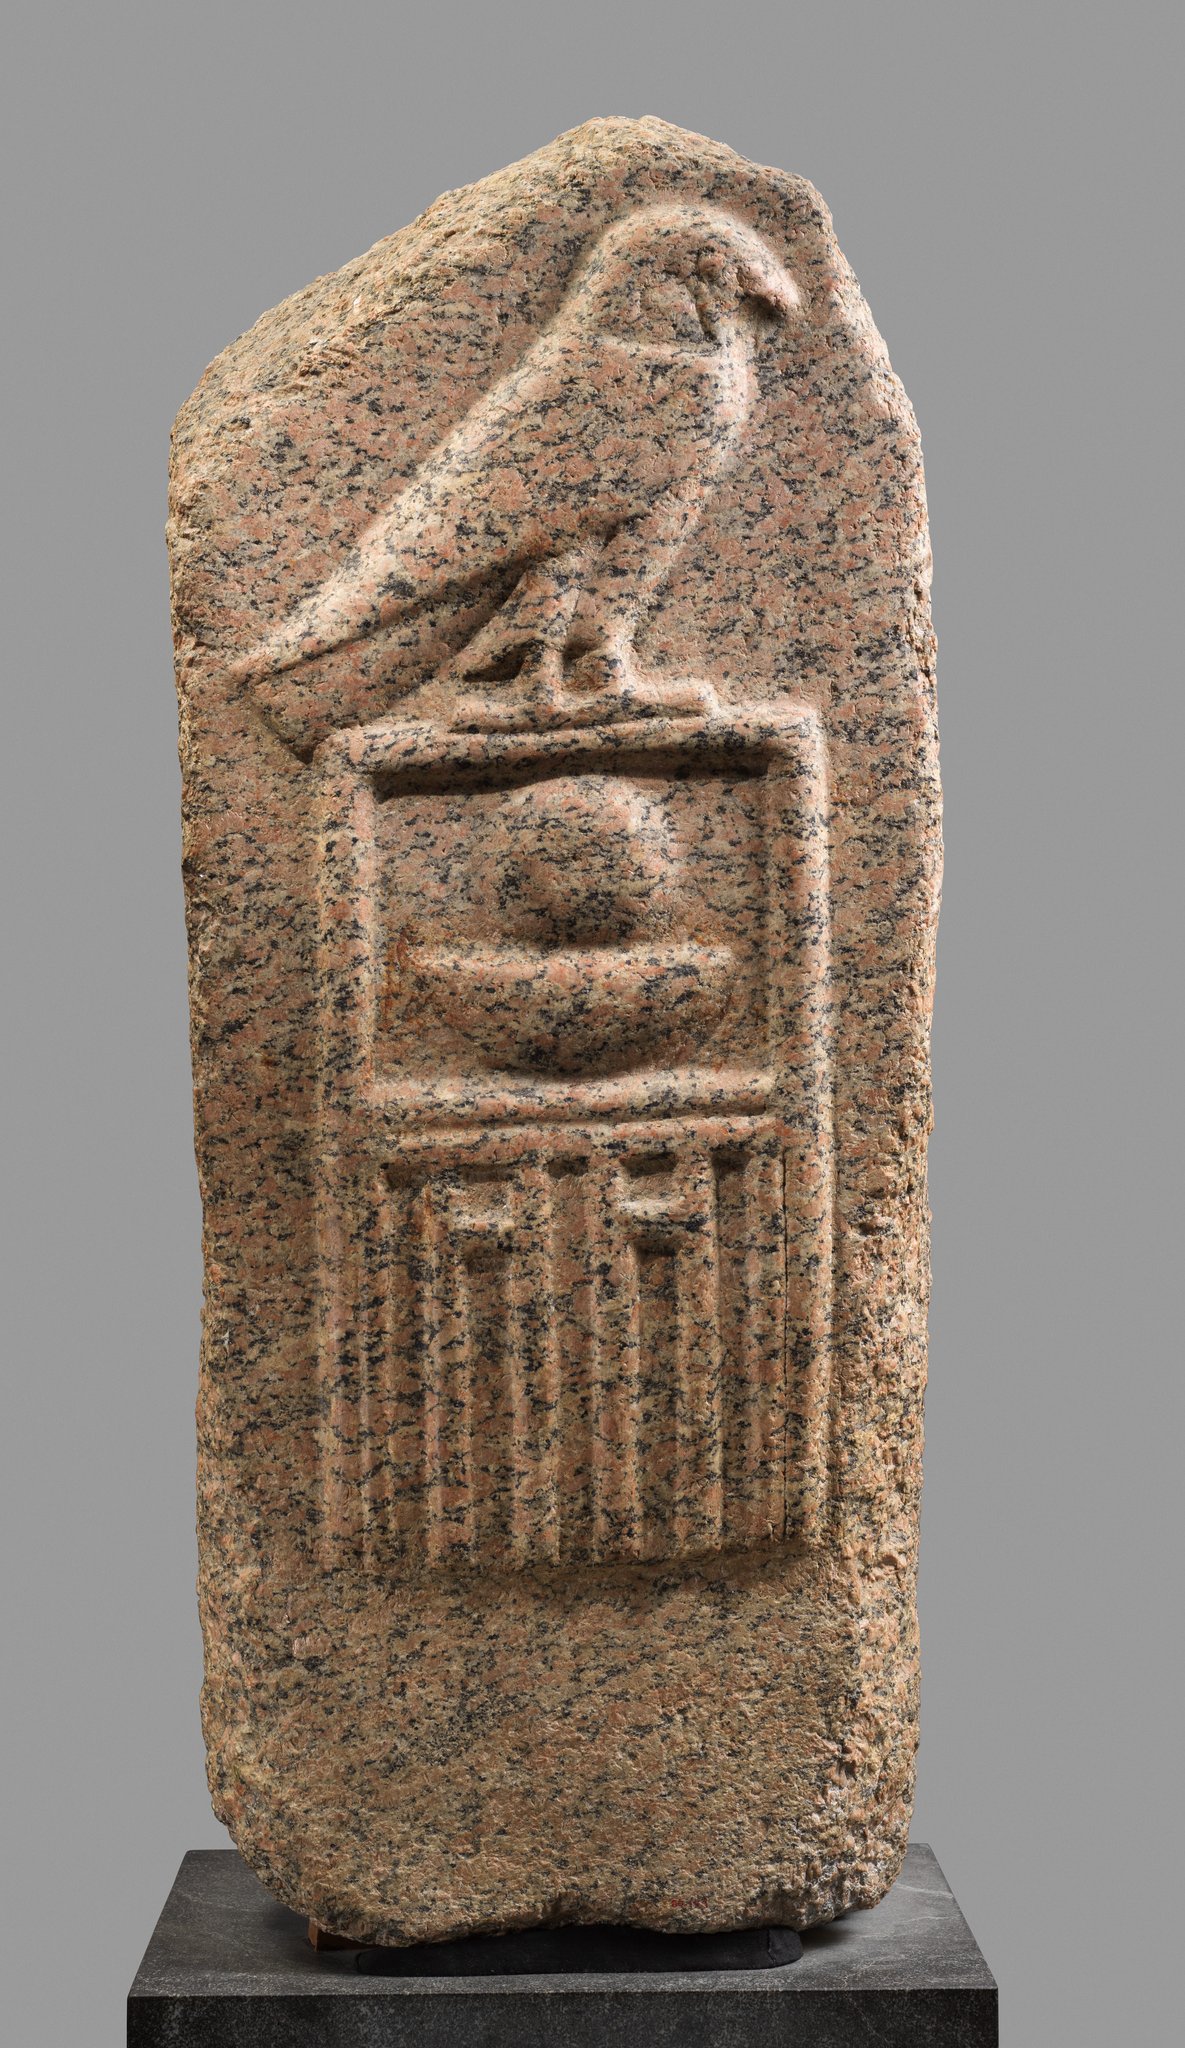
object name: stela, raneb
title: Stela of King Raneb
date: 2880 BCE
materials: granite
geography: memphite region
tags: birds